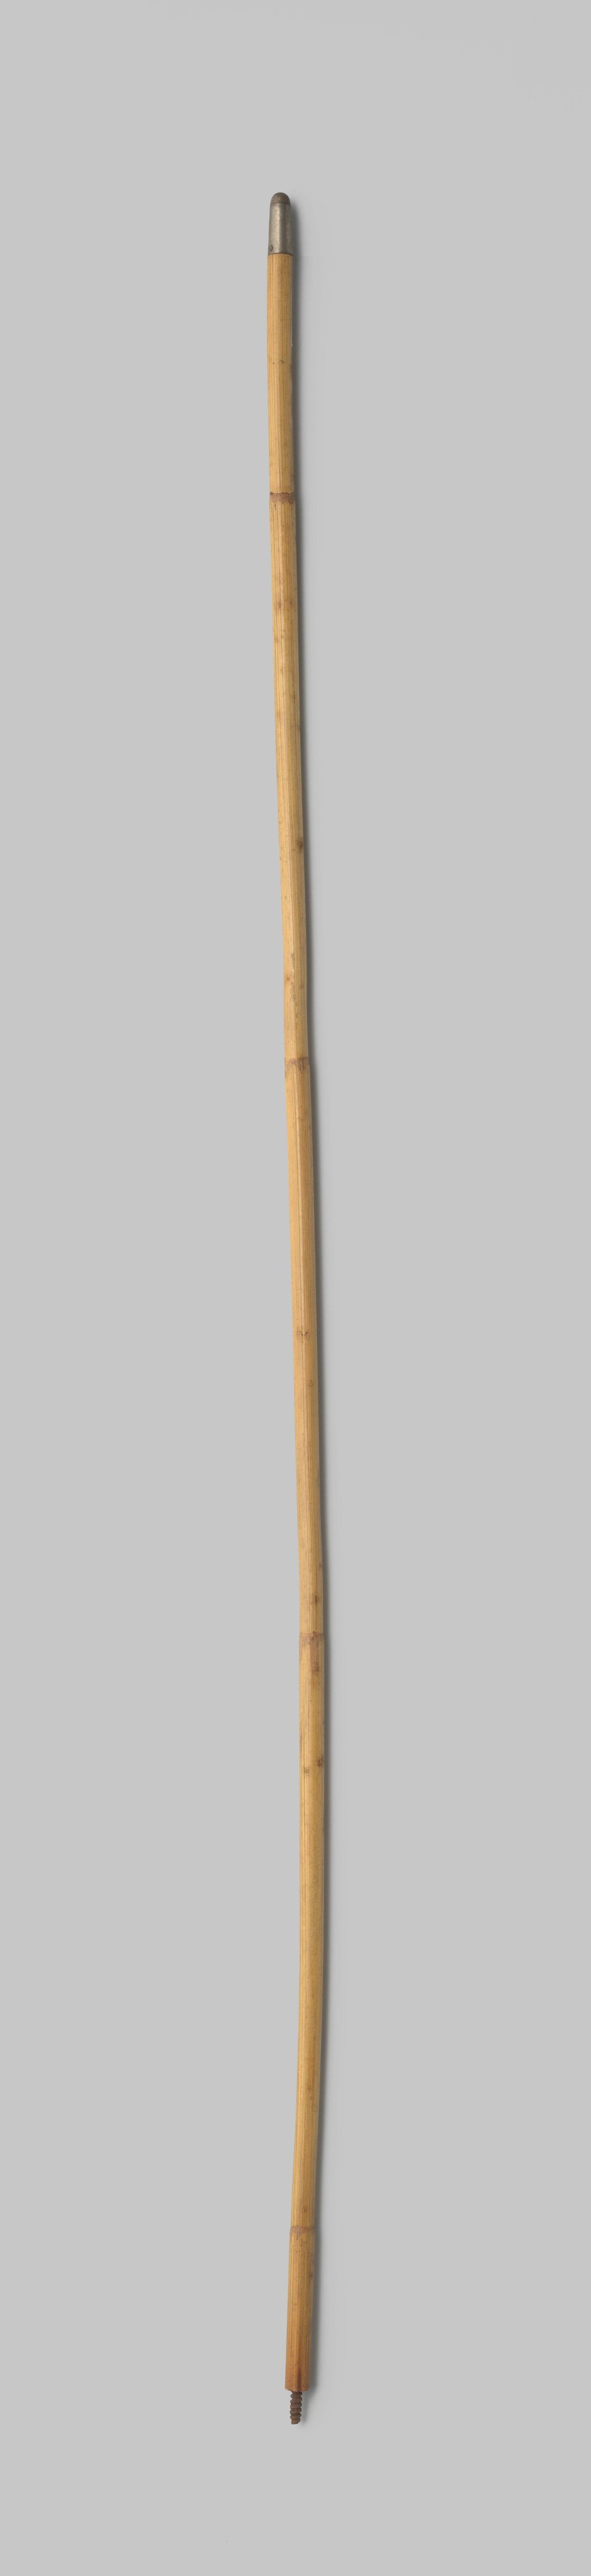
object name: onderstok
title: Onderstok van parasol of parapluie van bamboe met metalen schroefdraad en punt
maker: gustav schnitzler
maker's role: paraplufabrikant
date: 1920-1940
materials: bamboo, metal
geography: nijmegen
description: Onderstok van een parapluie of parasol van bamboe met aan het ene uiteinde een metalen schroefdraad en aan het andere uiteinde een metalen punt.